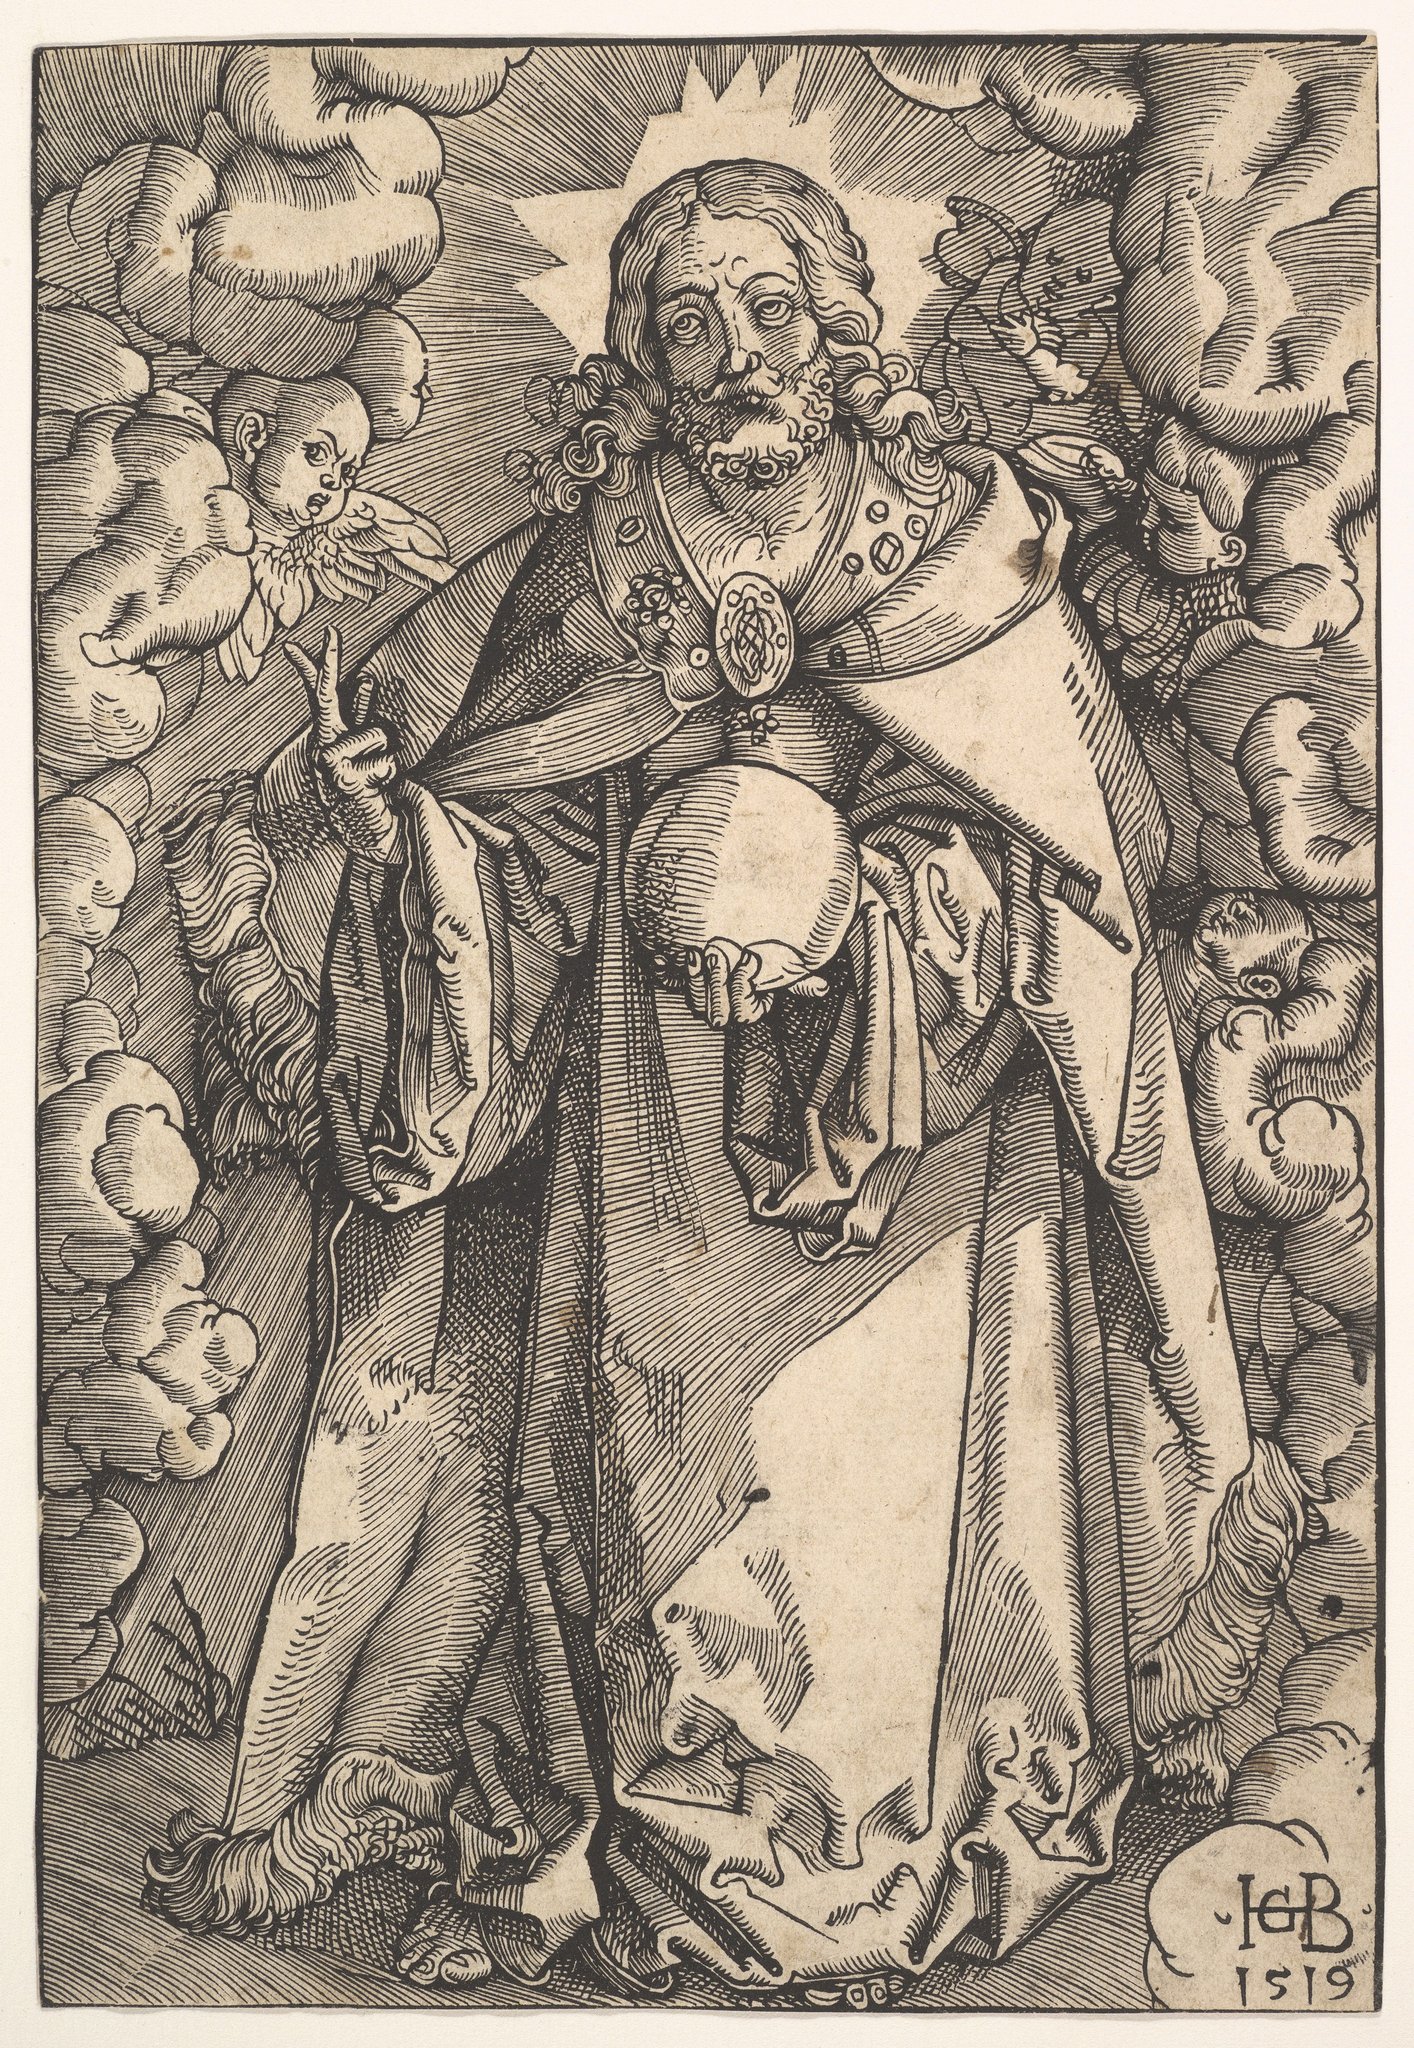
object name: print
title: Christ with the Orb of the World in His Left Hand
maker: hans baldung (called hans baldung grien)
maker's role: artist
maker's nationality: german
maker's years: 1484-1545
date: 1519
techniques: woodcut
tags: angels,christ